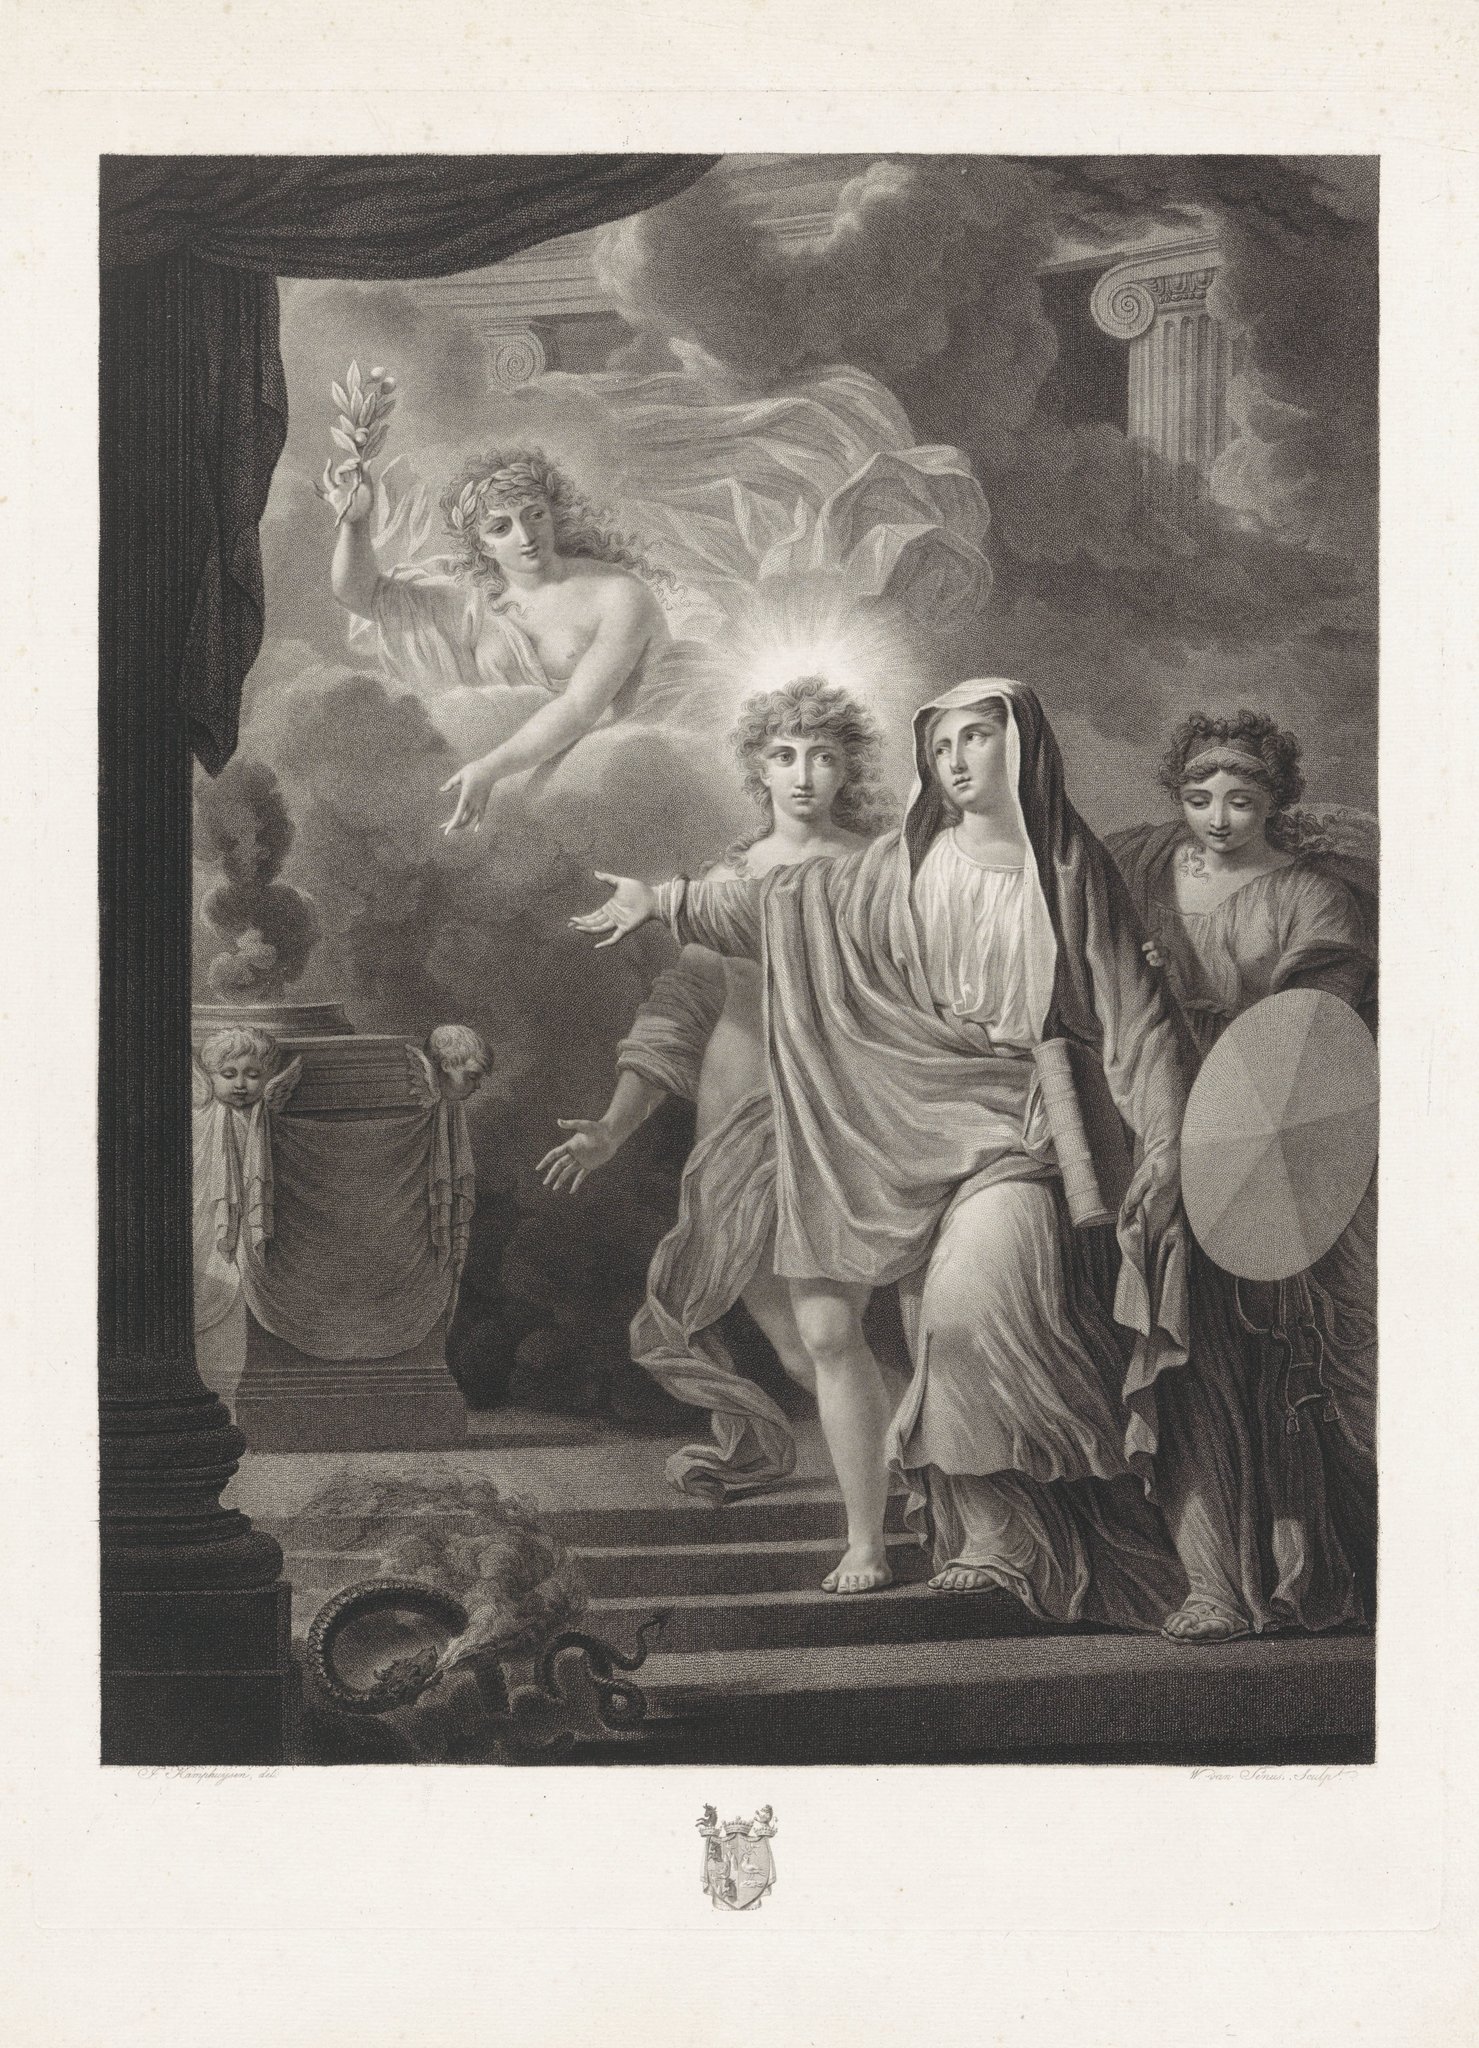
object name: print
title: De Godsdienst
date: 1802-1812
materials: paper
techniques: engraving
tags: faith, 'fides'; 'fede', 'fede catholica', 'fede christiana', 'fede christiana catholica' (ripa) ~ one of the three theological virtues, symbols, allegories of peace, 'pax'; 'pace' (ripa), wisdom; 'sapienza', 'sapienza humana', 'sapienza vera' (ripa), truth; 'verità' (ripa)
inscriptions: collector's mark: Lugt 2228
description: Godsdienst staat bij een altaar, waaraan een doek hangt met het opschrift "God is vrede". Zij wordt geflankeerd door twee allegorische figuren, mogelijk Wijsheid en Waarheid. Boven hen kijkt vanuit de wolken Vrede toe. Linksonder spuwt een slang zijn verderfelijke adem. Onder de prent een wapenschild.